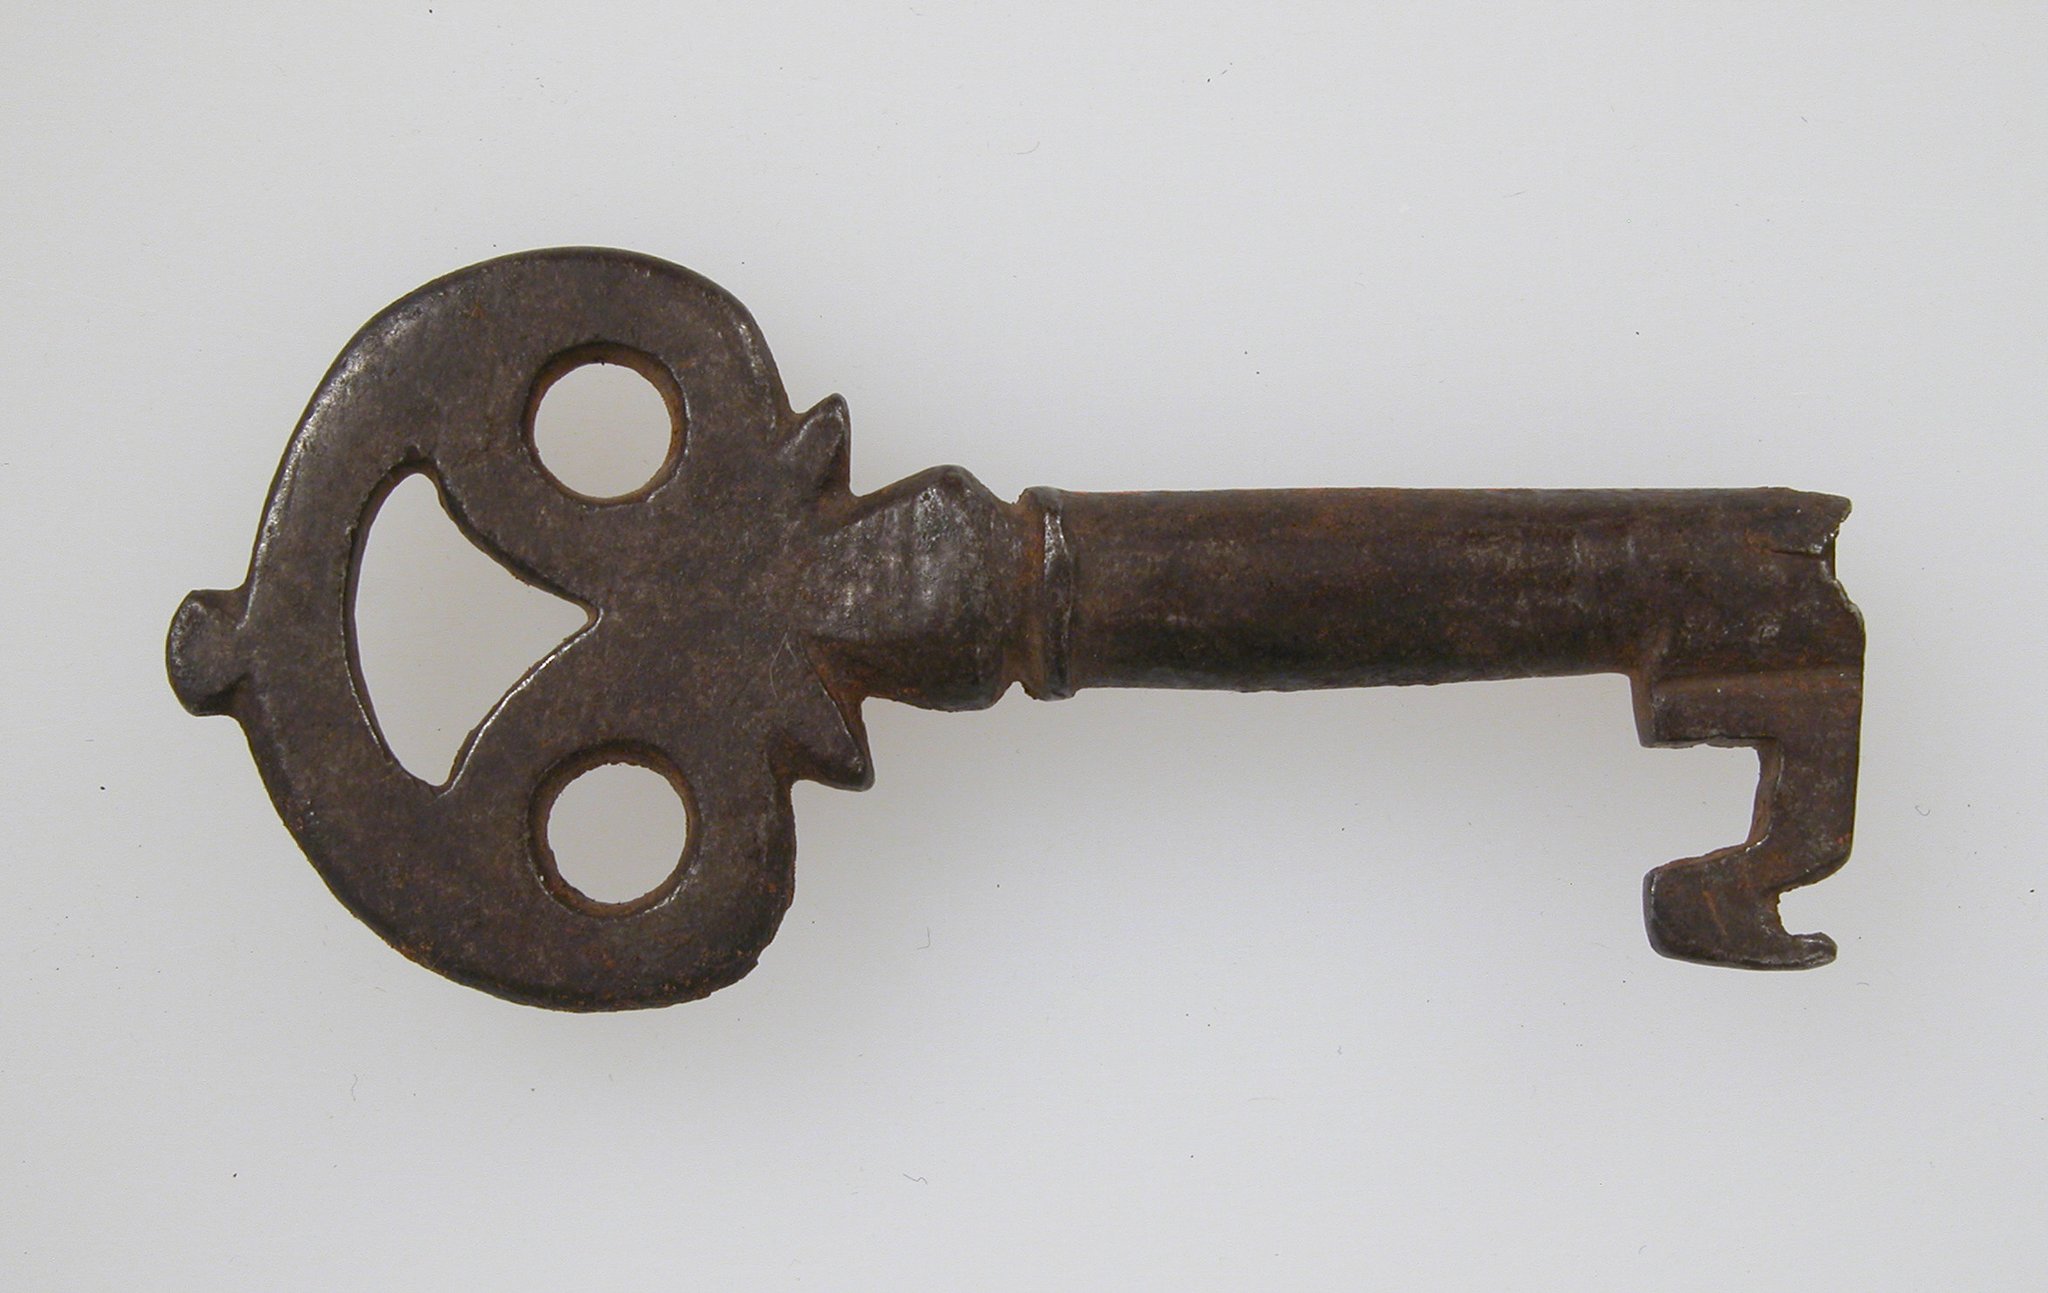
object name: key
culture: german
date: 1401-1500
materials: iron